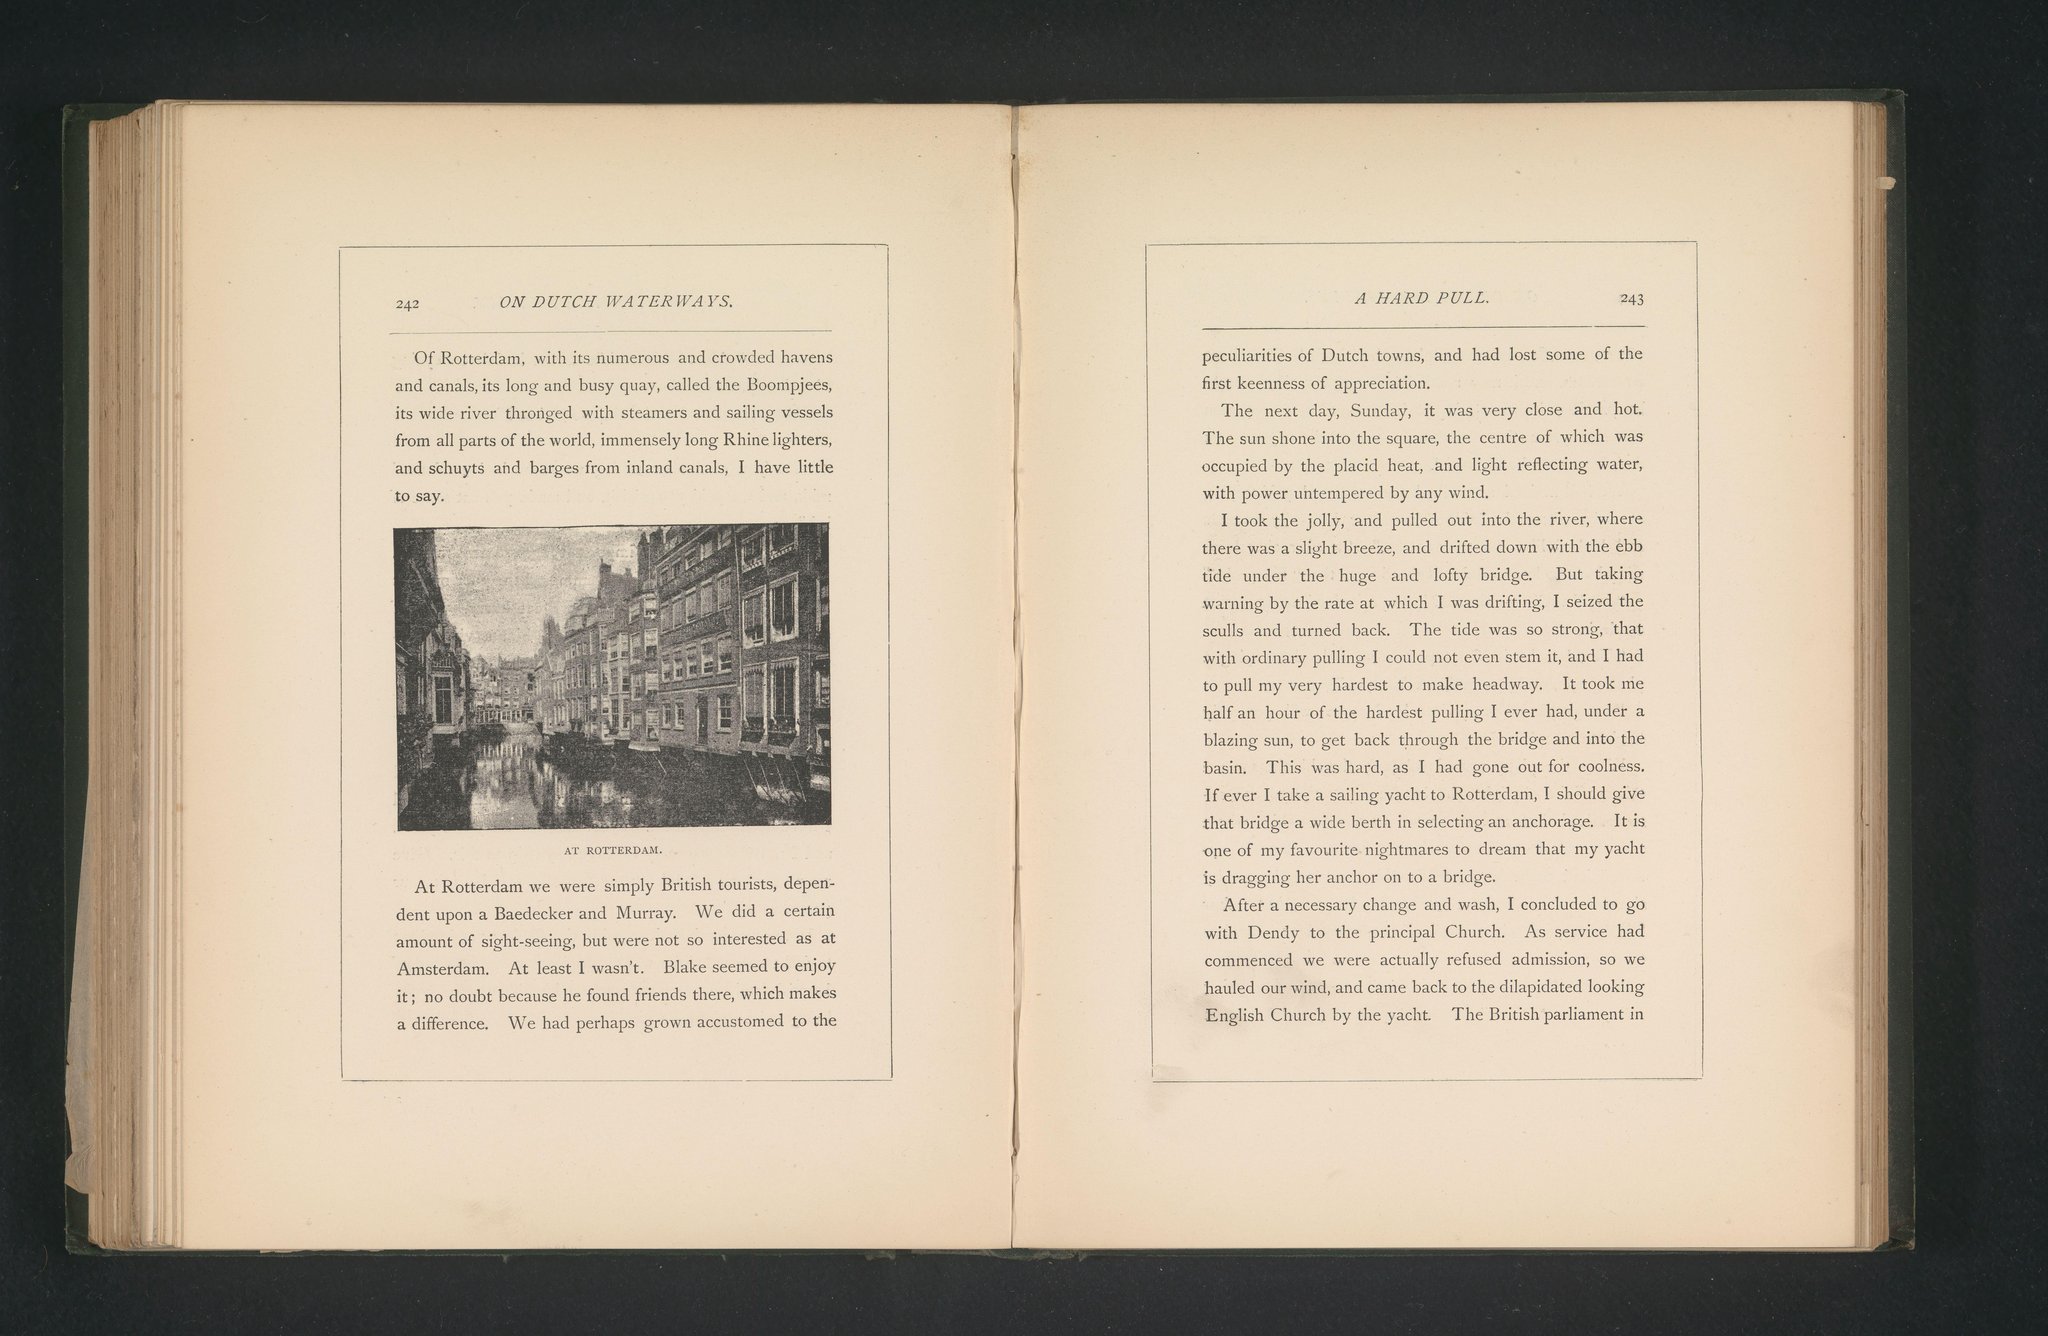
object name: photomechanical print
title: Gezicht op een rij huizen in Rotterdam, vanaf het water gezien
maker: george christopher davies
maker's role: fotograaf, geoloog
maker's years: 1849-1922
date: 1881-1886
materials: paper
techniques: autotype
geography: rotterdam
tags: canals, waters (in city), the usual house or row of houses, rotterdam